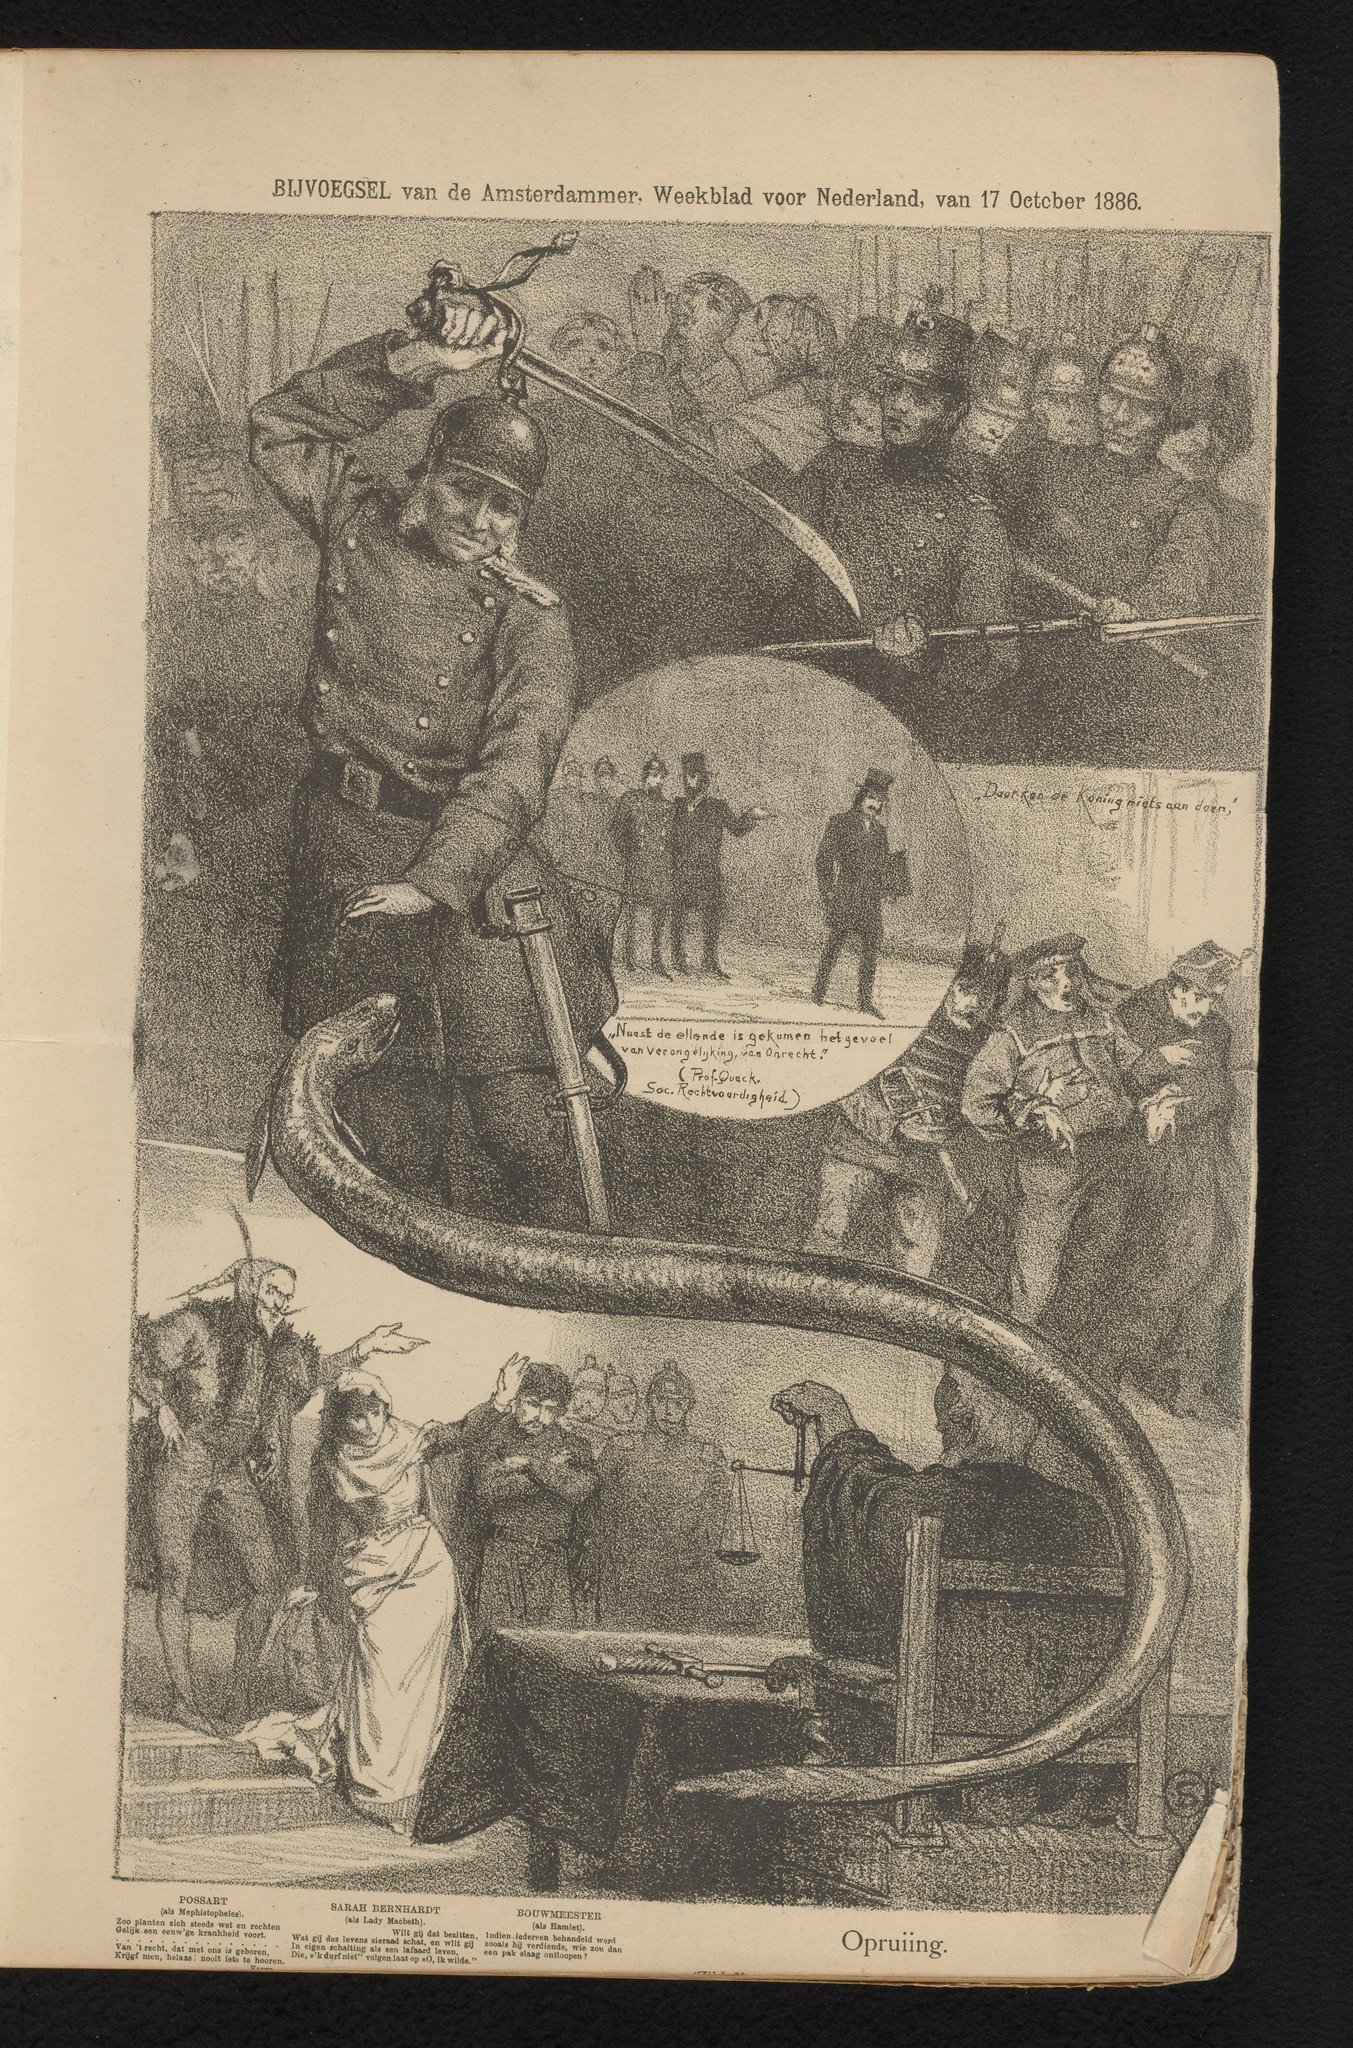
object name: cartoon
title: Opruiing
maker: willem steelink (ii)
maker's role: draughtsman, print maker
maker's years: 1856-1928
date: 1886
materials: paper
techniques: lithograph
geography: amsterdam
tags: paris, sarah bernhardt, group of actors, troupe; actors on the stage, street-fights, riots, court session (court of justice), political caricatures and satires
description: Blad met diverse taferelen uit het binnenland. Centraal een paling neergeslagen door een politieagent met een sabel. Bovenaan voorstellingen van de hardhandige onderdrukking van het Palingoproer in Amsterdam op 25-26 juli 1886. Onderaan een rechtbankscène in een toneelstuk met Sarah Bernhardt en Louis Bouwmeester.